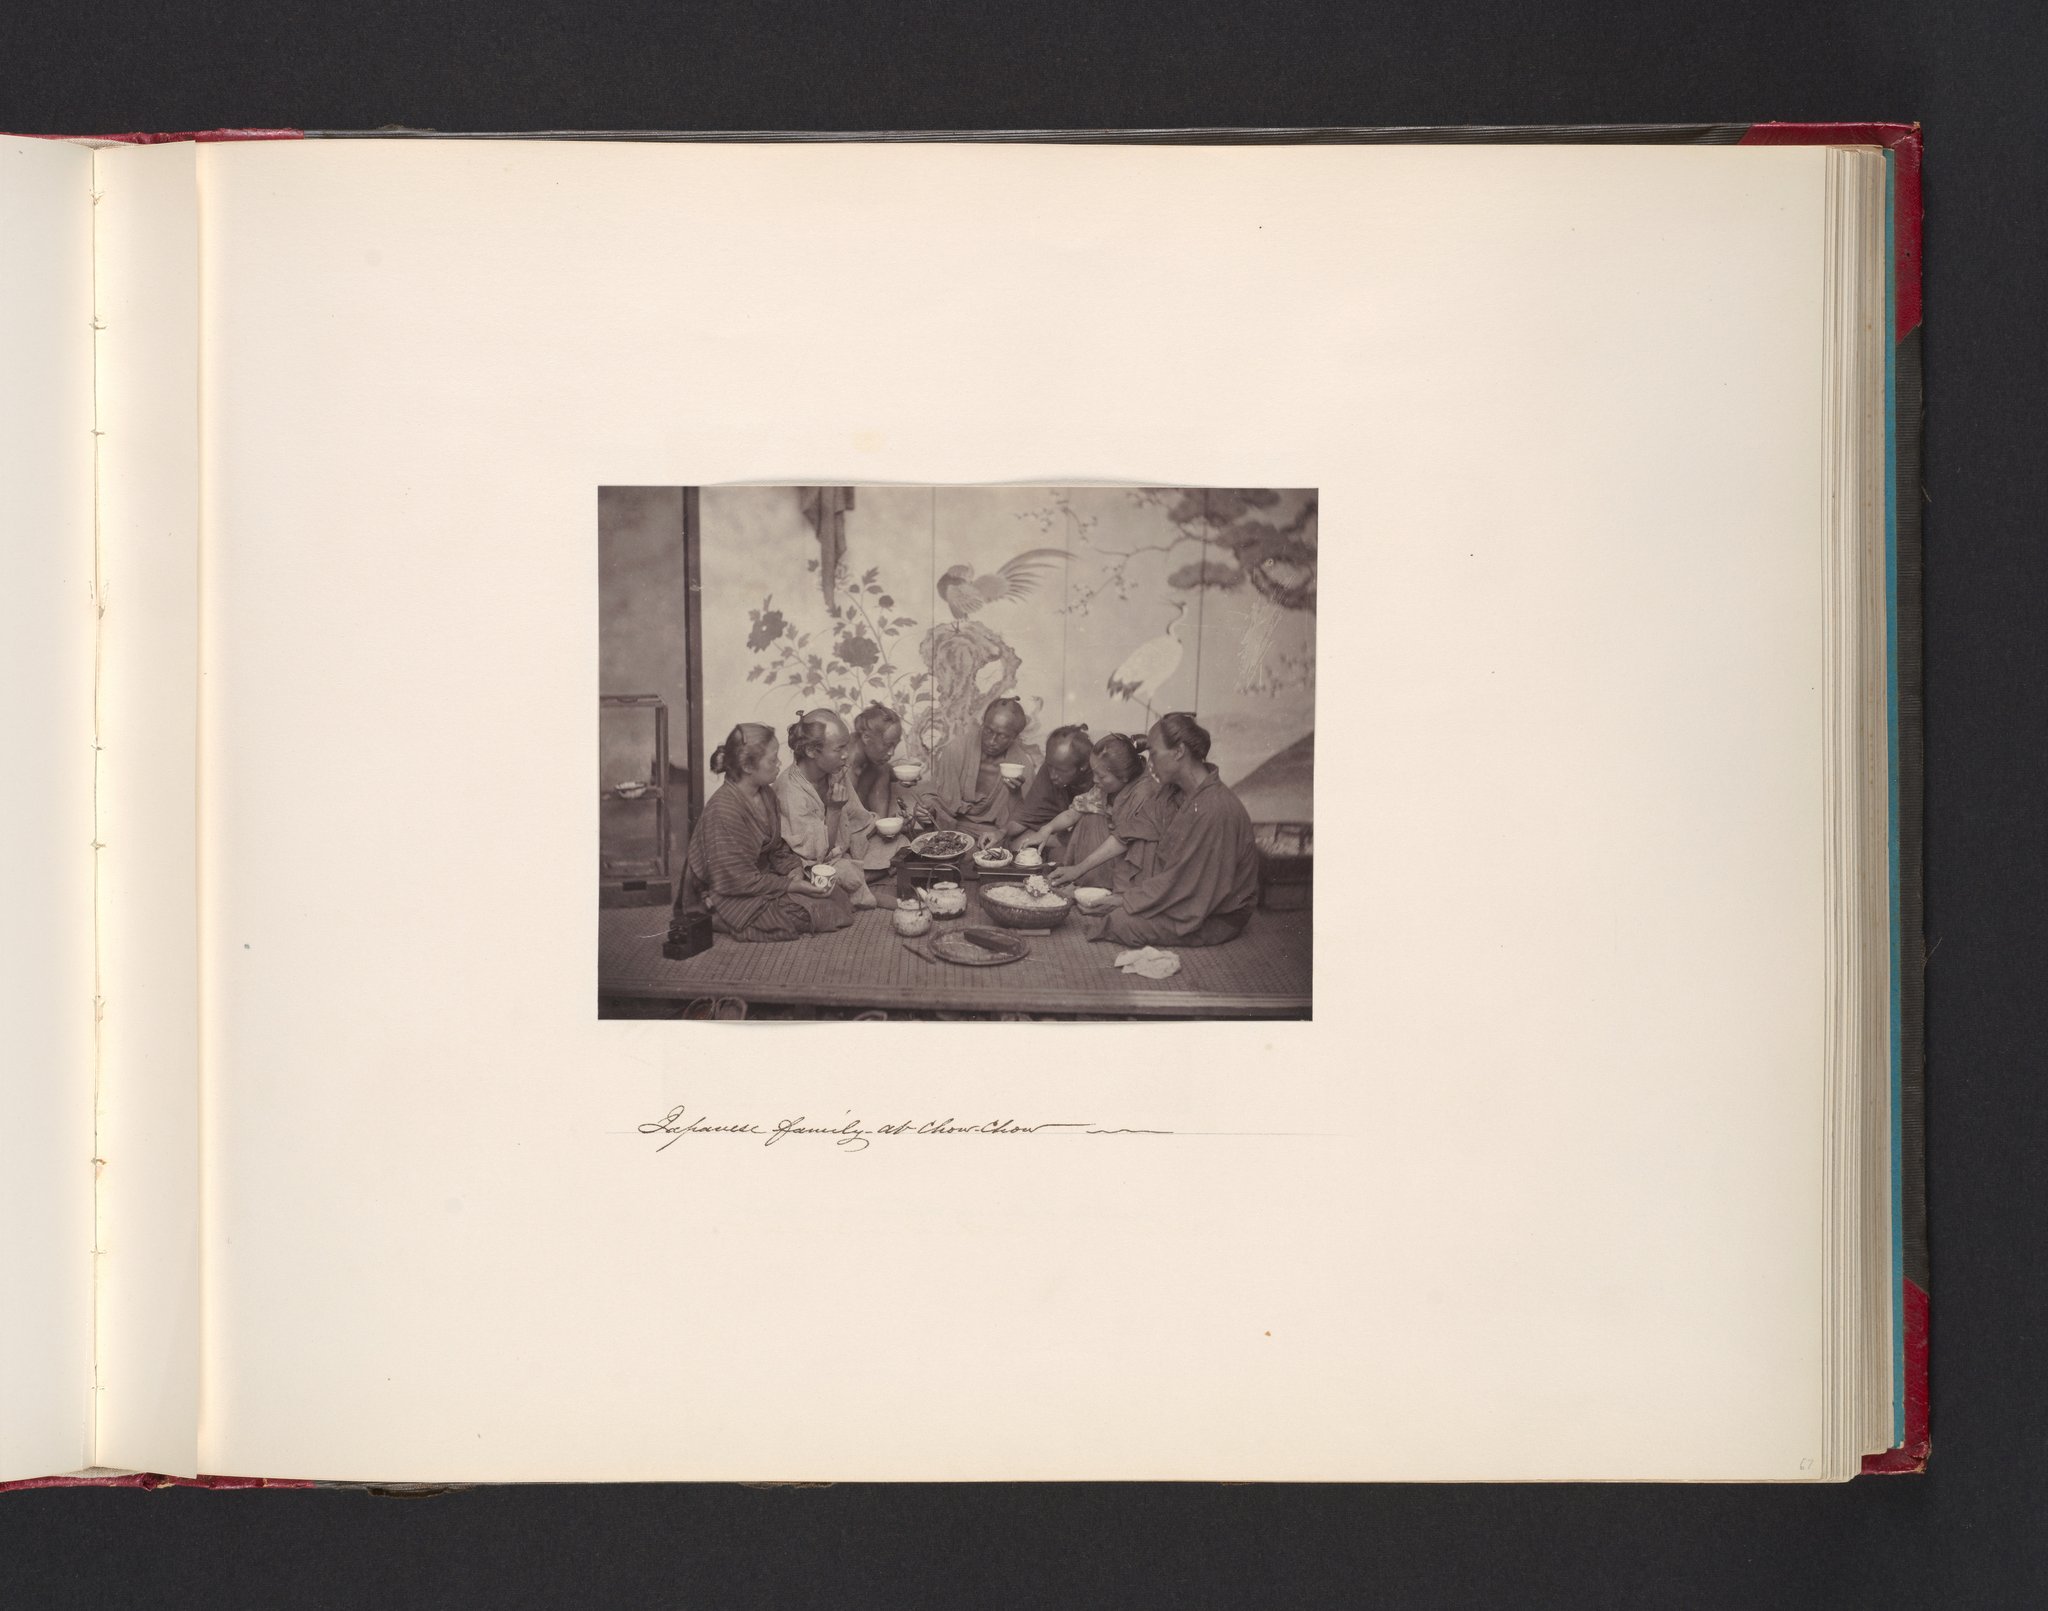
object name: photograph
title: Japanese Family at Chow-Chow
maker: john thomson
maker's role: artist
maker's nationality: british, scottish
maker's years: 1837-1921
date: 1865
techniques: albumen silver print, glass negative